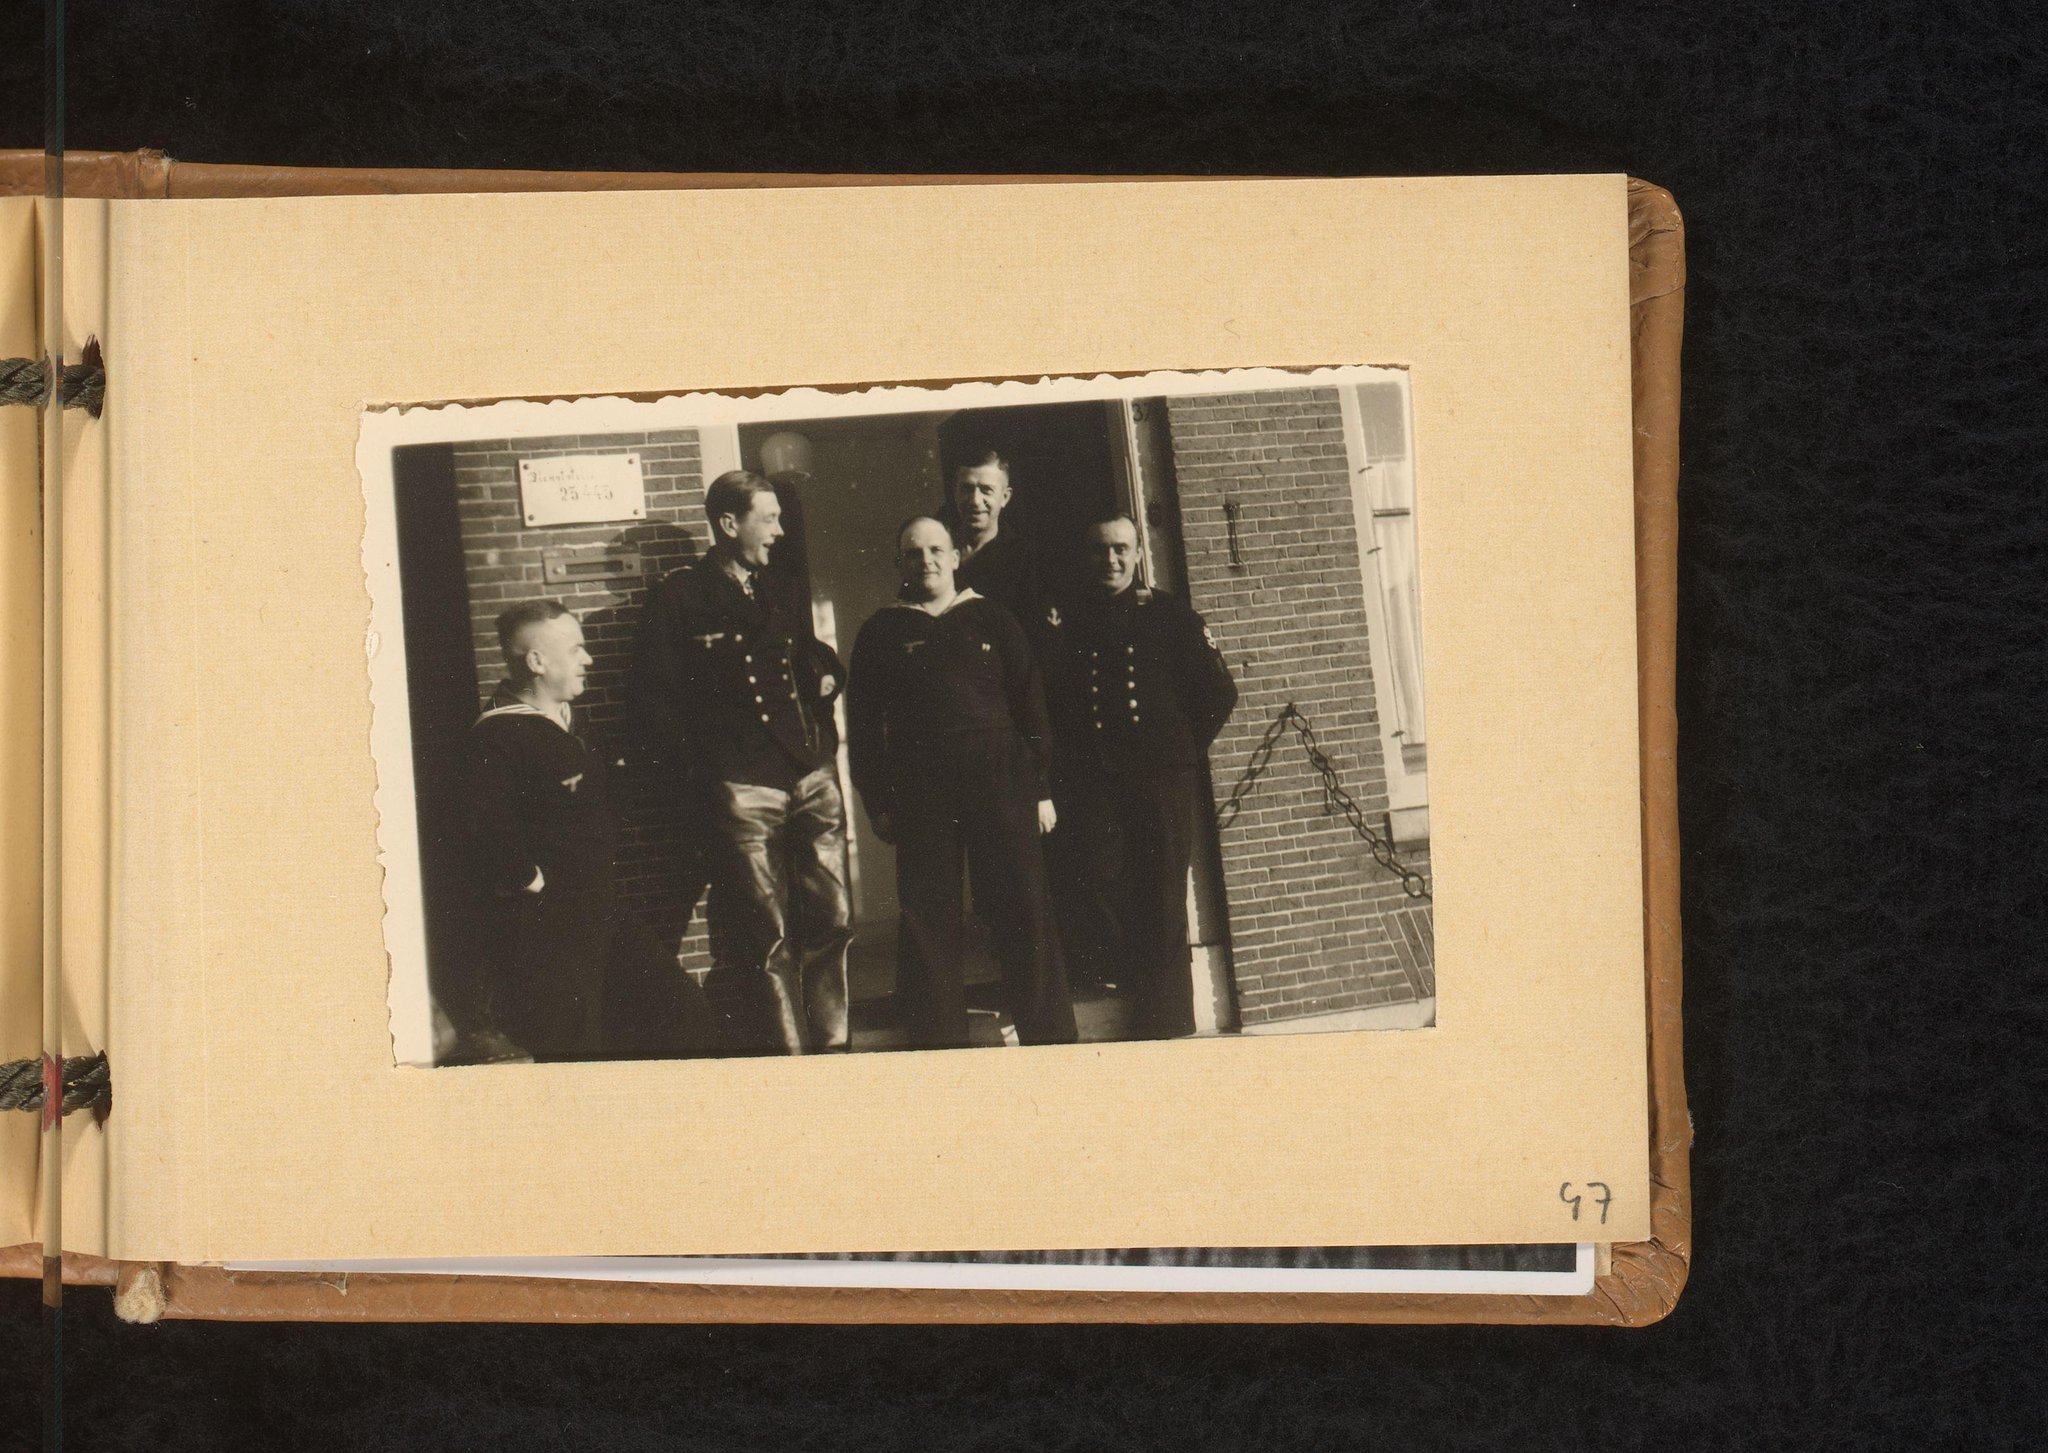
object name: album leaf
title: Staande militairen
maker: Anonymous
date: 1940-1943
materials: paper, photographic support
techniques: gelatin silver print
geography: netherlands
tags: the company, the unit, the troop ~ military service, shelter ~ military service, occupation ~ war, netherlands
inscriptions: inscription: ‘Mit frit...’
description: Albumblad met een foto van vijf militairen staande in de deuropening van het onderkomen van de Kriegsmarine in Nederland: Dienststelle 23 443. Onderdeel van een klein album van de Kriegsmarine in Nederland.